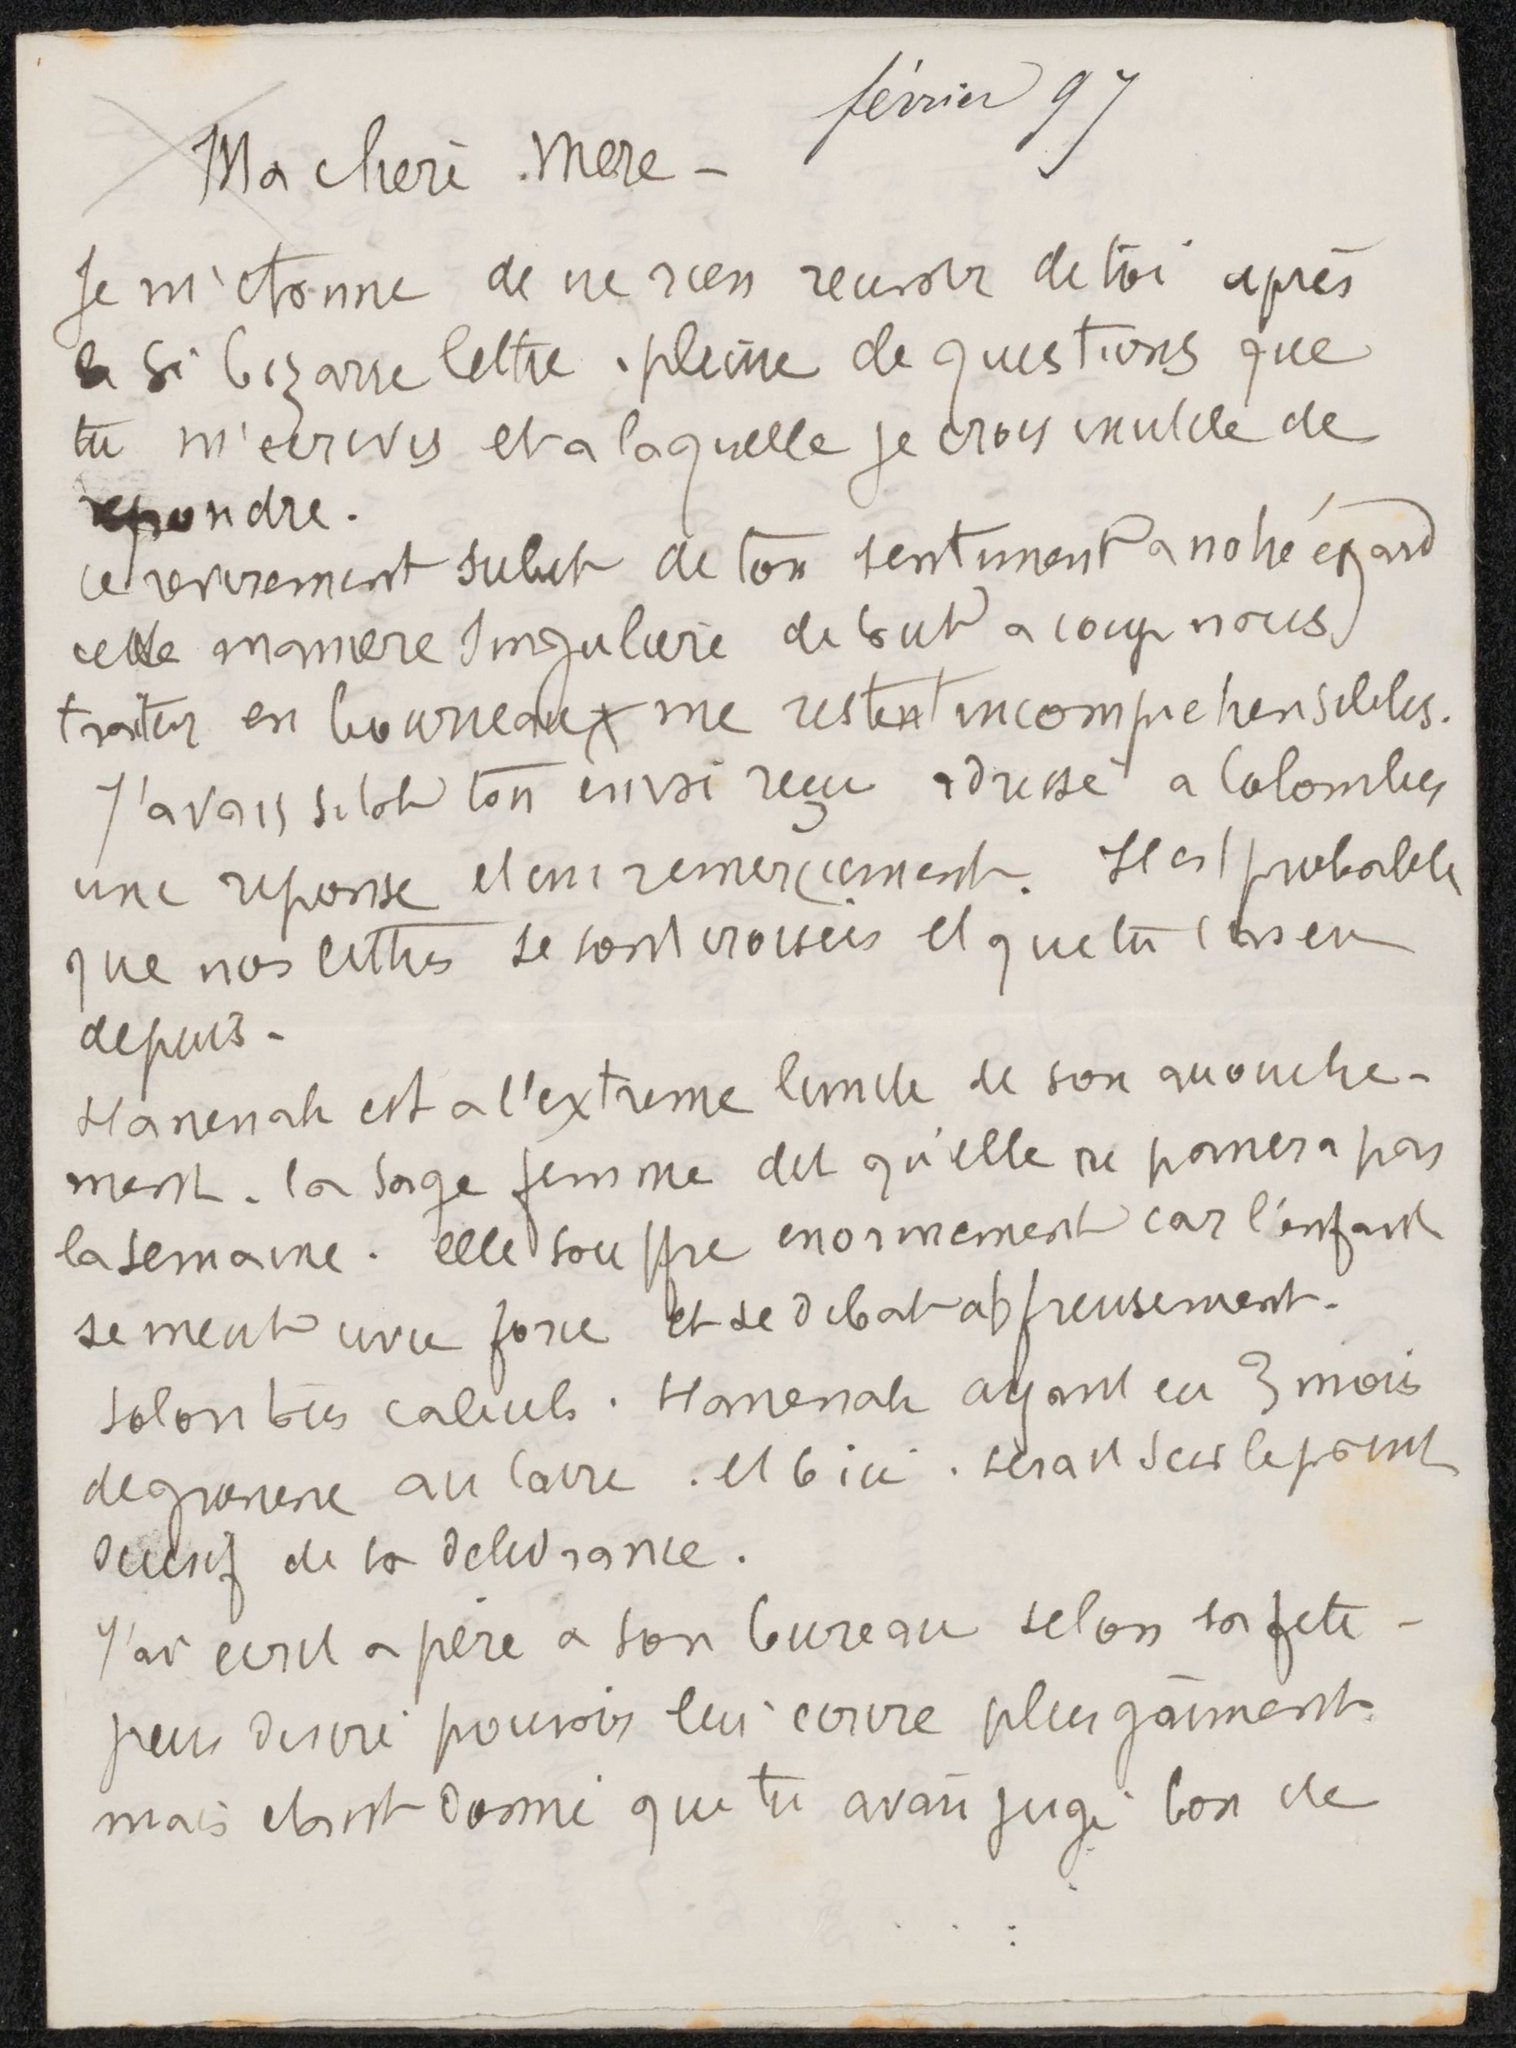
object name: letter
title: Brief aan Héloïse Bernard-Bodin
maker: émile bernard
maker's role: print maker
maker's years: 1868-1941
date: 1802-1897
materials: ink, paper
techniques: pen, writing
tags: héloïse bernard-bodin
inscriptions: watermark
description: Brief gedateerd février 97 in latere hand.